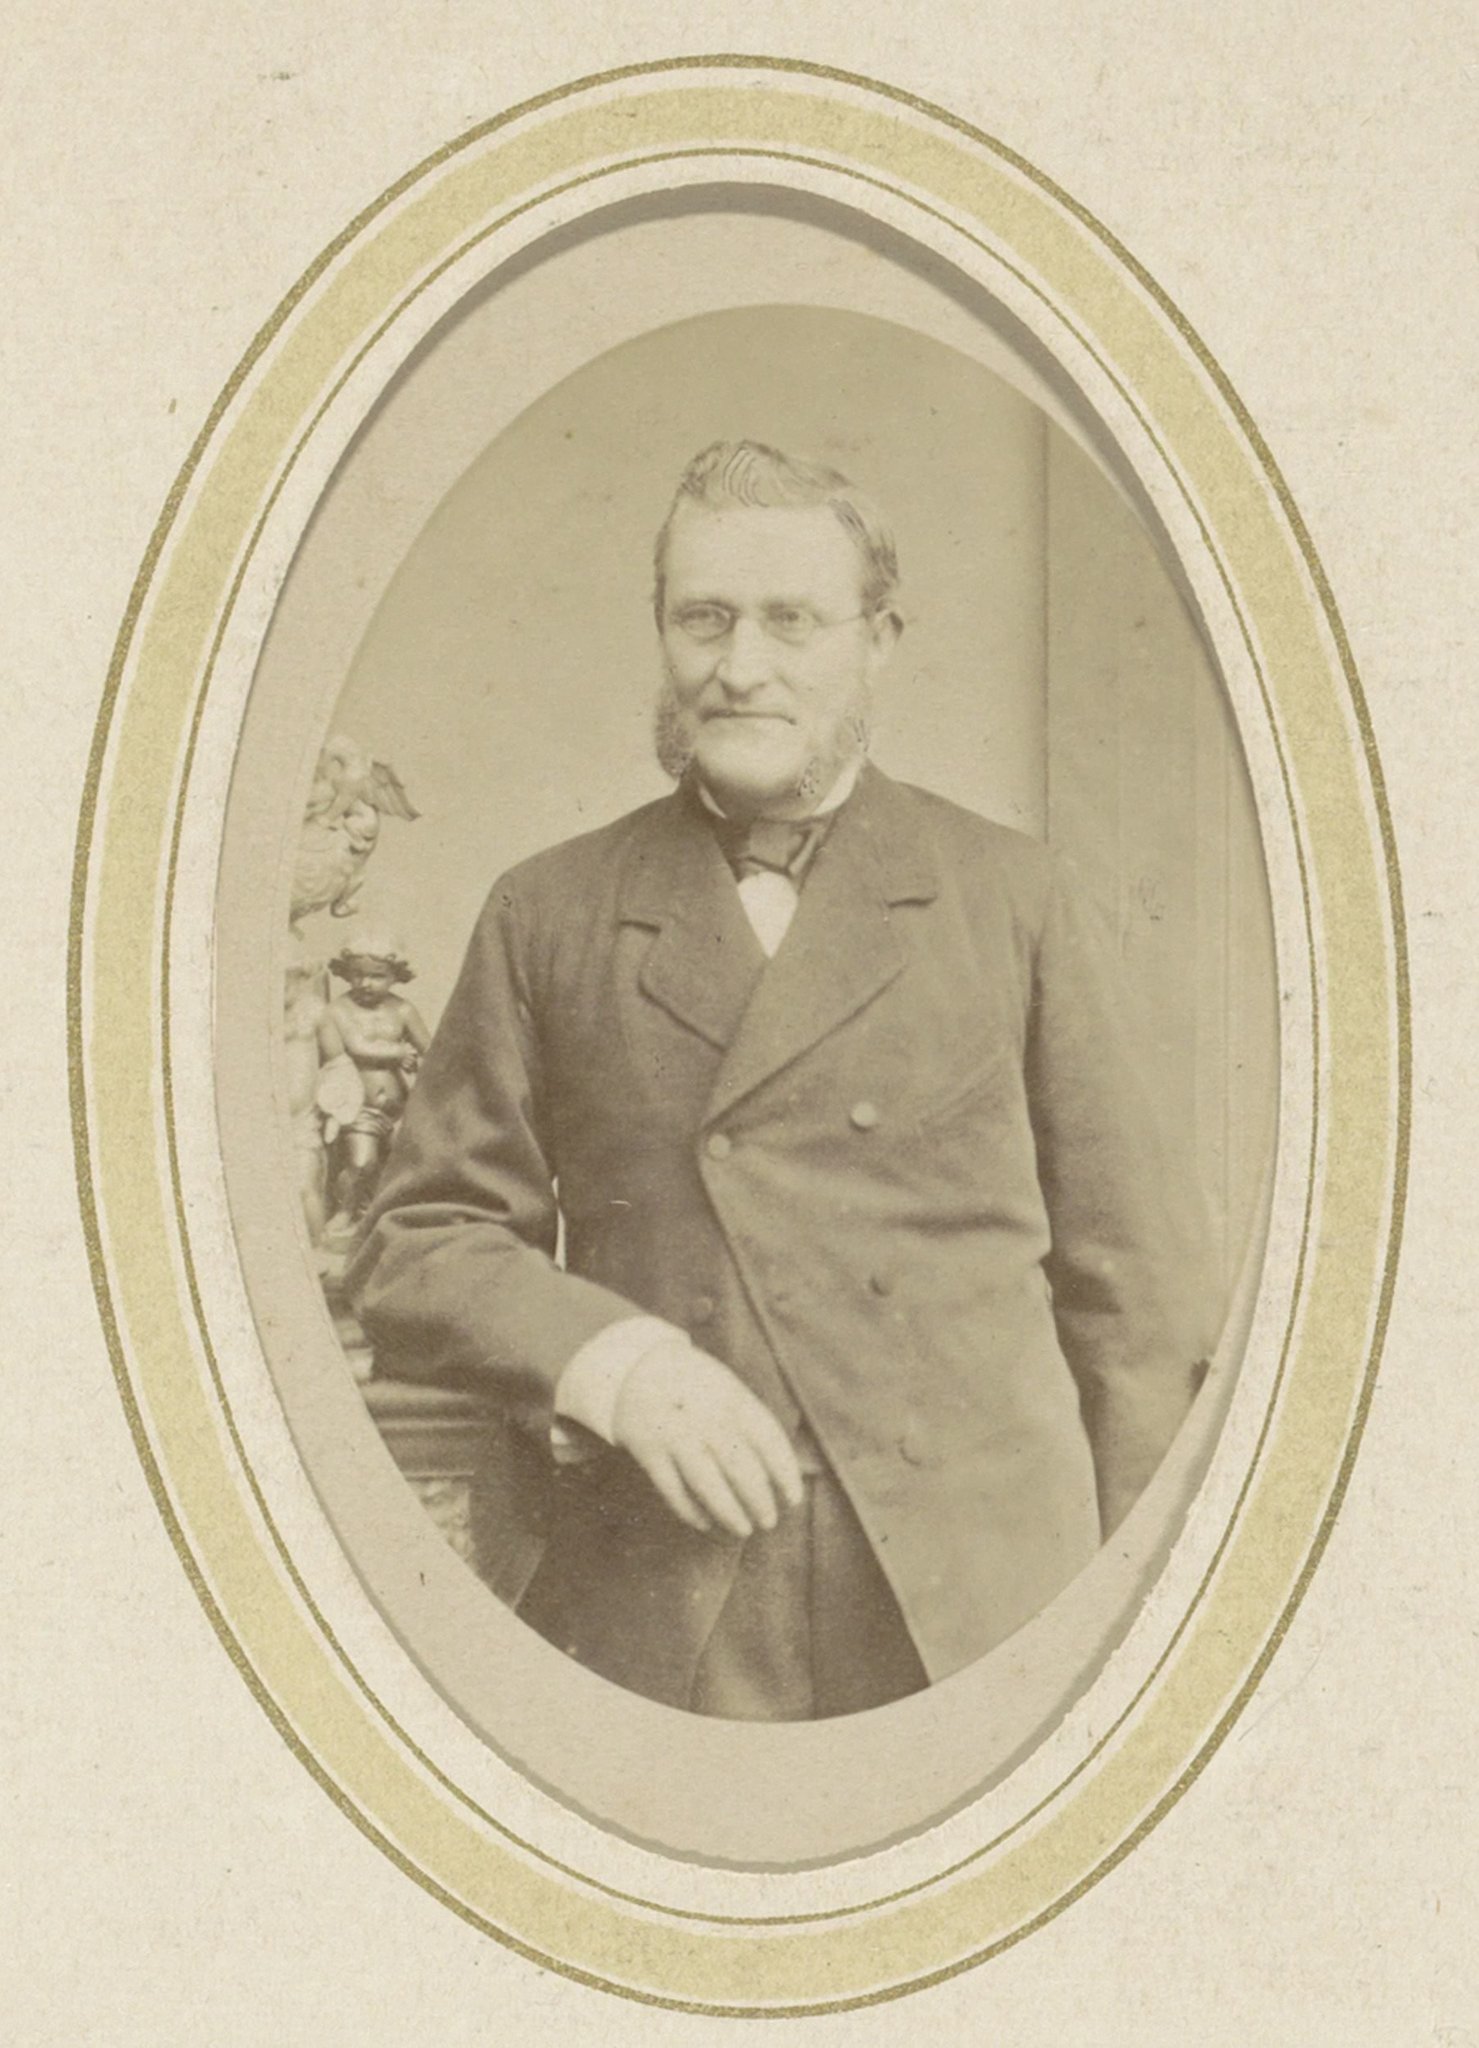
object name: photograph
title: Portret van een leunende man met een baard en een bril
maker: johannes ephraim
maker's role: fotograaf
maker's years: 1838-1921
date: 1867-1904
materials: cardboard, paper, photographic support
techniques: albumen print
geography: arnhem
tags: eyeglasses, spectacles, studio requisites ~ photographer, historical persons, clothing for the upper part of the body, beard, arnhem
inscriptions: address: ‘Rynkade 53 Arnhem’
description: Onderdeel van Fotoalbum van een Nederlandse familie met 168 cartes-de-visite en kabinetfoto's.